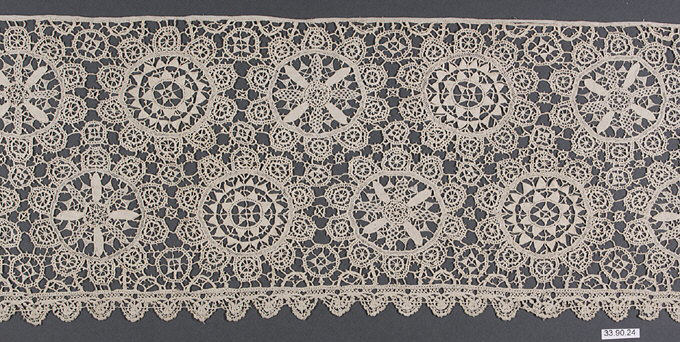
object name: flounce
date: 1601-1700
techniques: lace